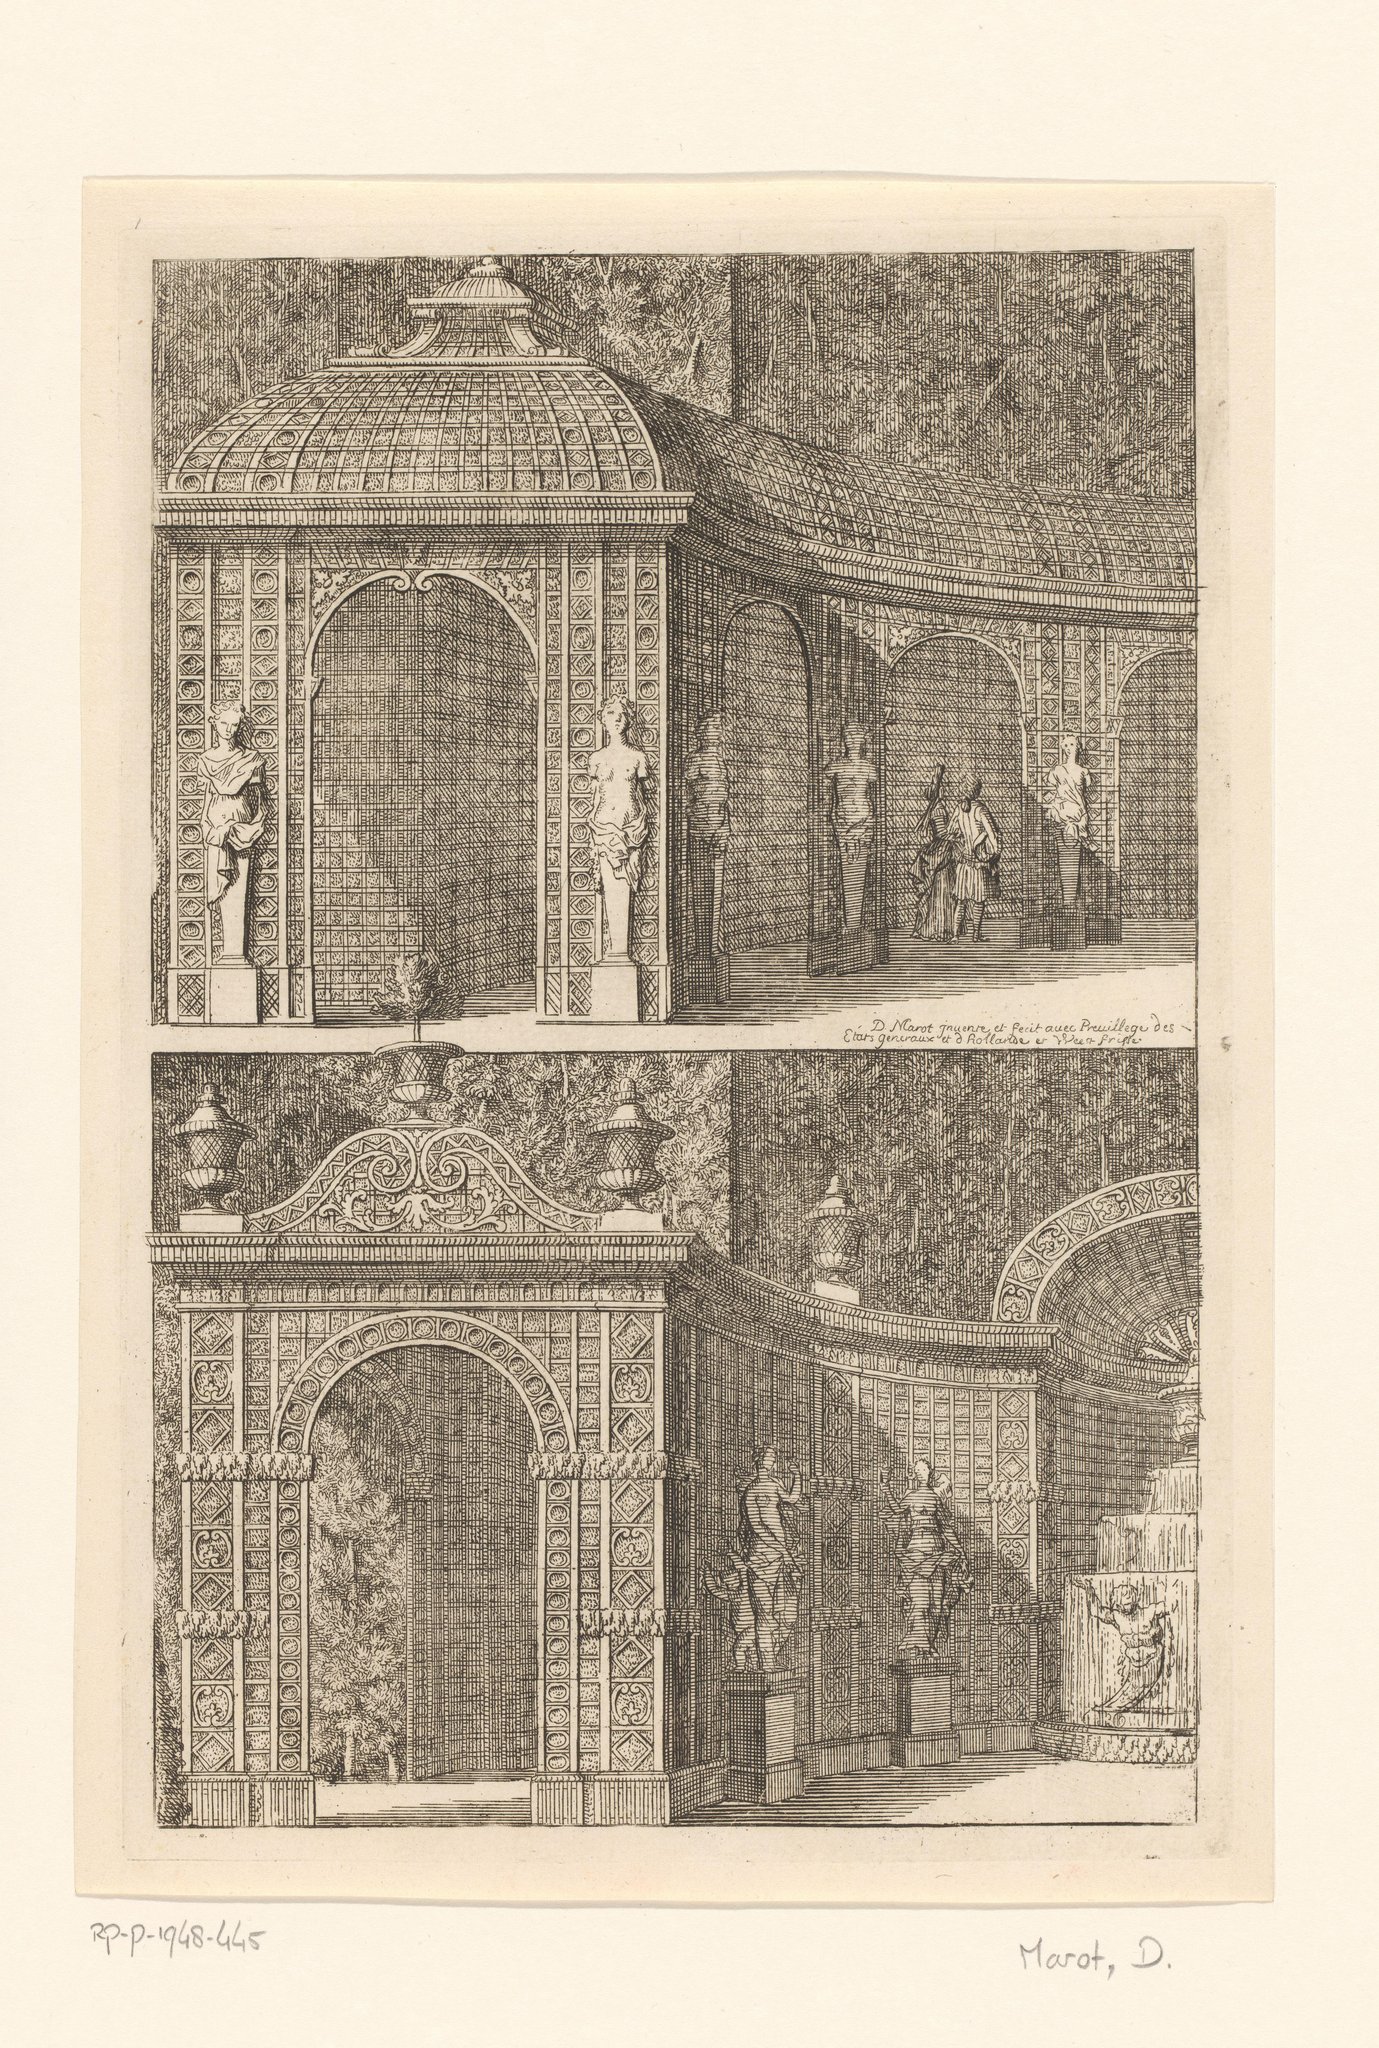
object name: print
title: Nouveaux Liure de Bersseaux et Trilliages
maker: daniël marot (i)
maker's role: draughtsman, print maker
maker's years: 1661-1752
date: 1702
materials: paper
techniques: etching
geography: the hague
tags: trellis, herms (garden ornaments), ornamental fountain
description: Twee latwerkgangen. De bovenste gang is gedecoreerd met termen, de onderste met een nis met daarin een fontein en een cascade.